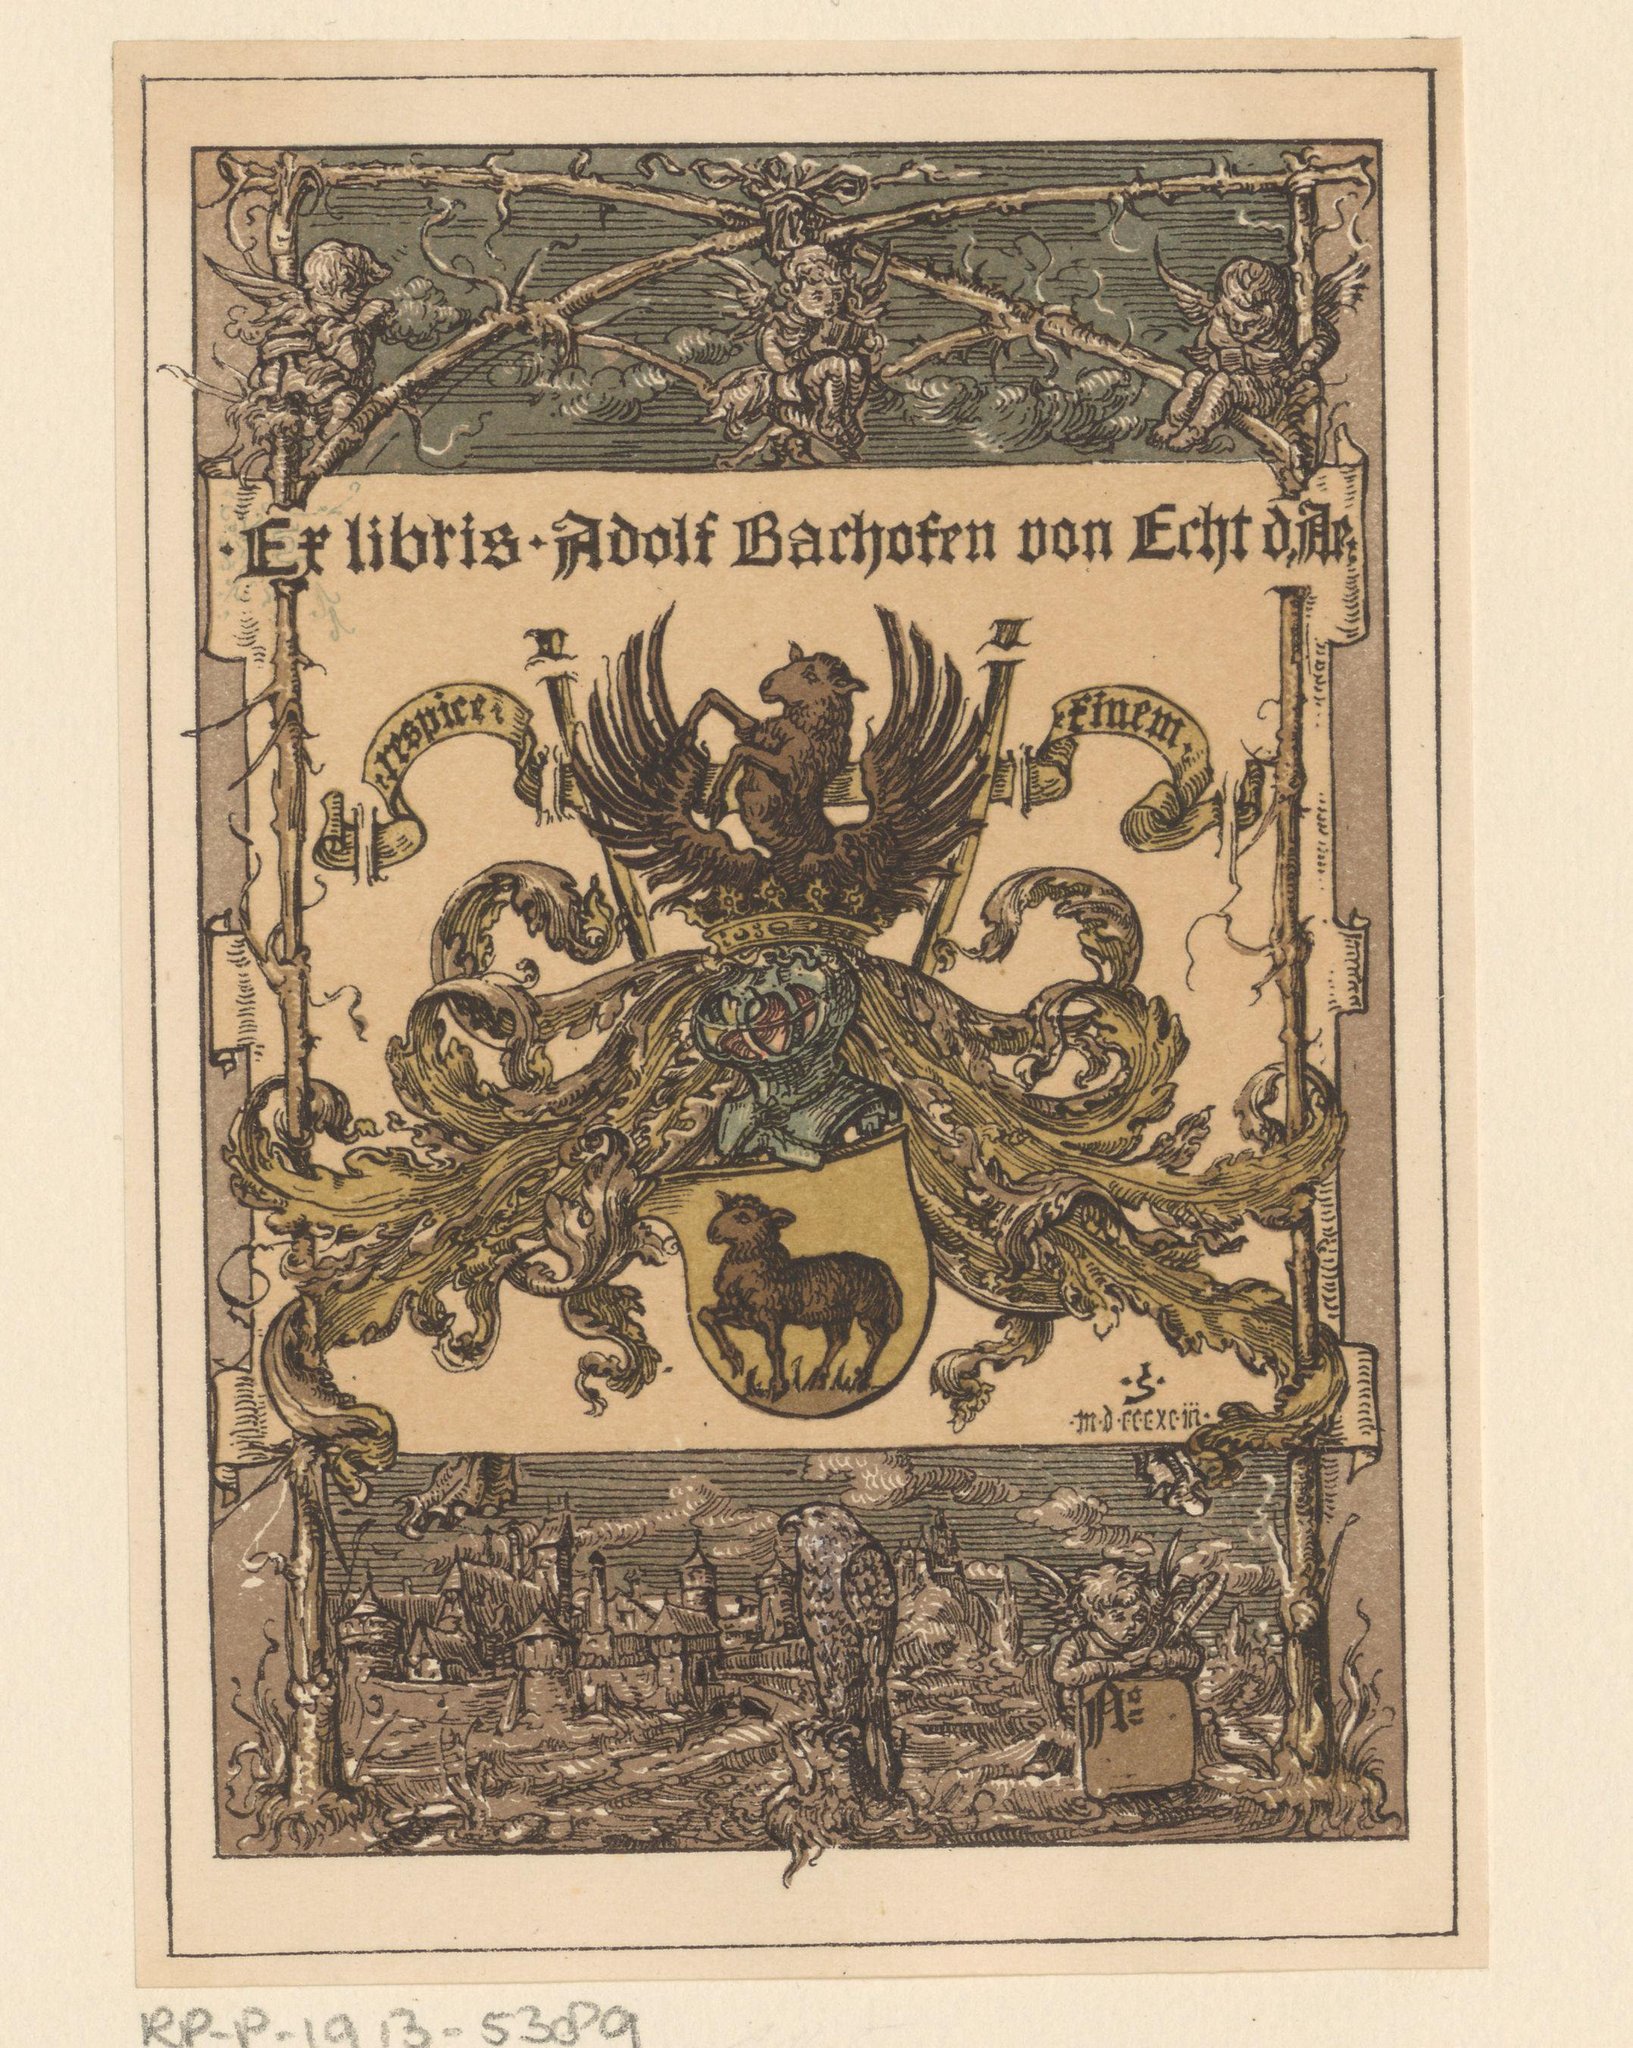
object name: bookplate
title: Ex libris van Adolf Bachofen von Echt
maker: joseph sattler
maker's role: painter, print maker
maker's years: 1867-1931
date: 1893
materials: paper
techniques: lithograph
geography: germany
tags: vienna, predatory birds, sheep, cupids: 'amores', 'amoretti', 'putti', armorial bearing, heraldry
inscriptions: collector's mark: Lugt 2233, collector's mark: Lugt 2760